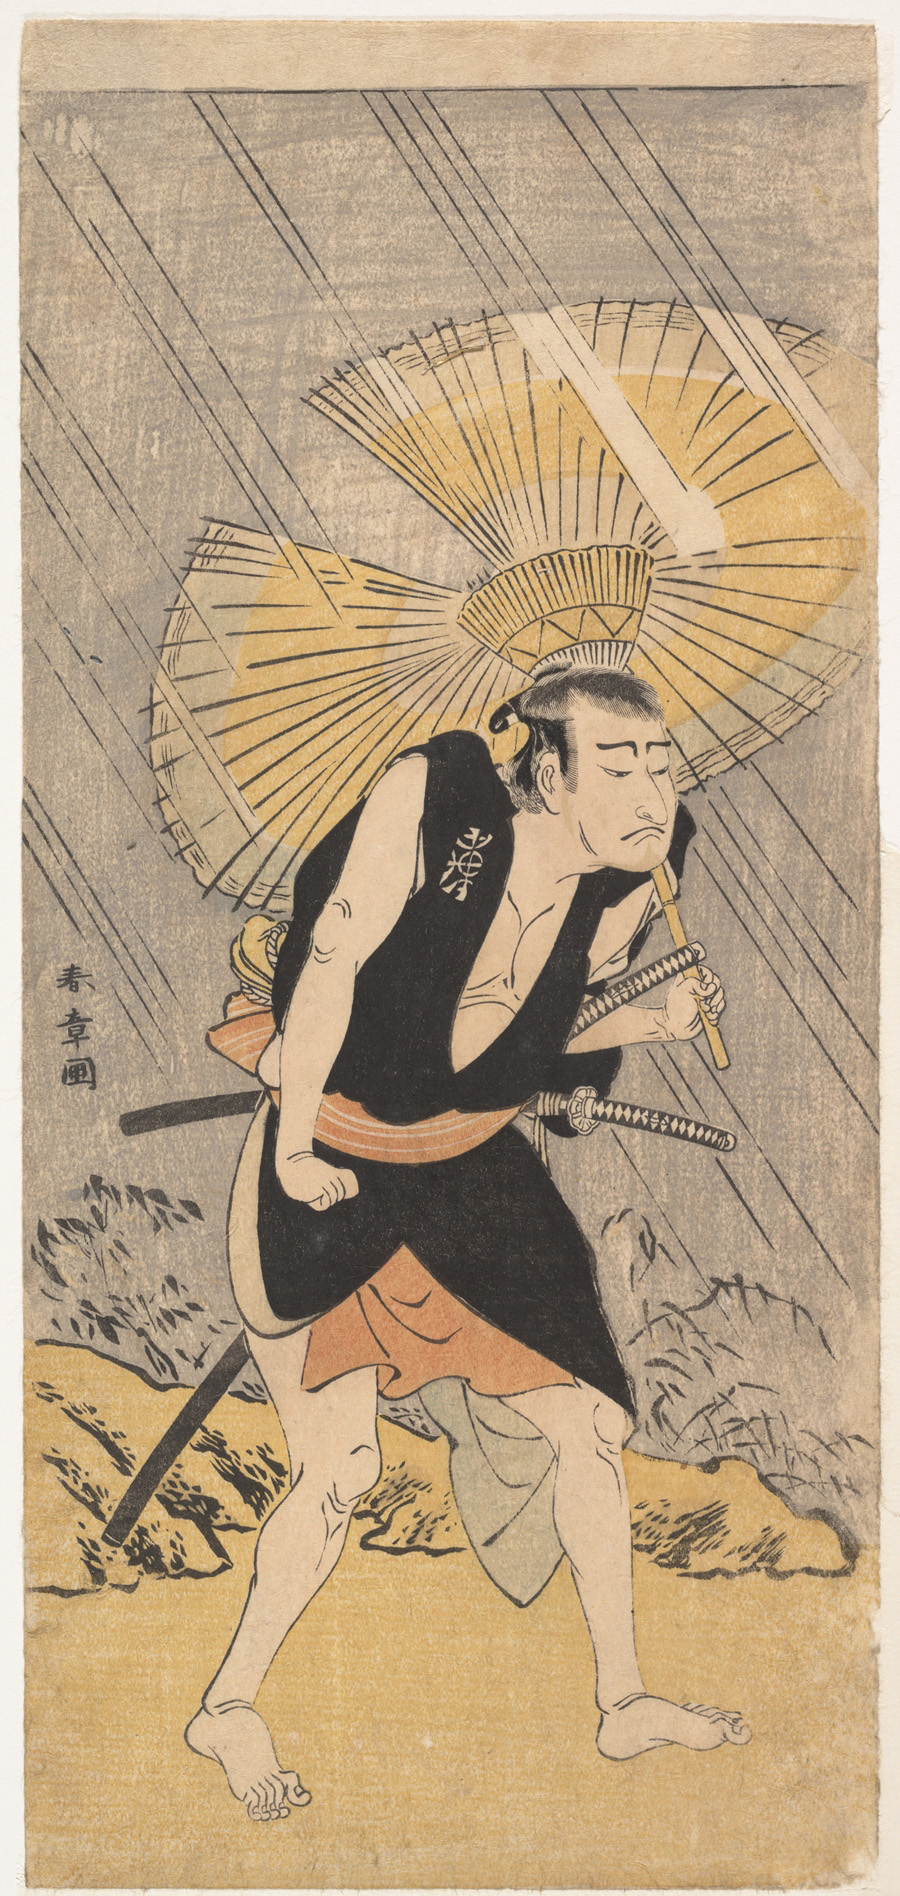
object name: woodblock print nishiki e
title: The Actor Nakamura Nakazō in the Role of Ono Sadakurō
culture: japanese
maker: katsukawa shunshō 勝川春章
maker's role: artist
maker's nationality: japanese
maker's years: 1726-1792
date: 1766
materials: ink, paper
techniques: nishiki e, woodblock print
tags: rain,actors